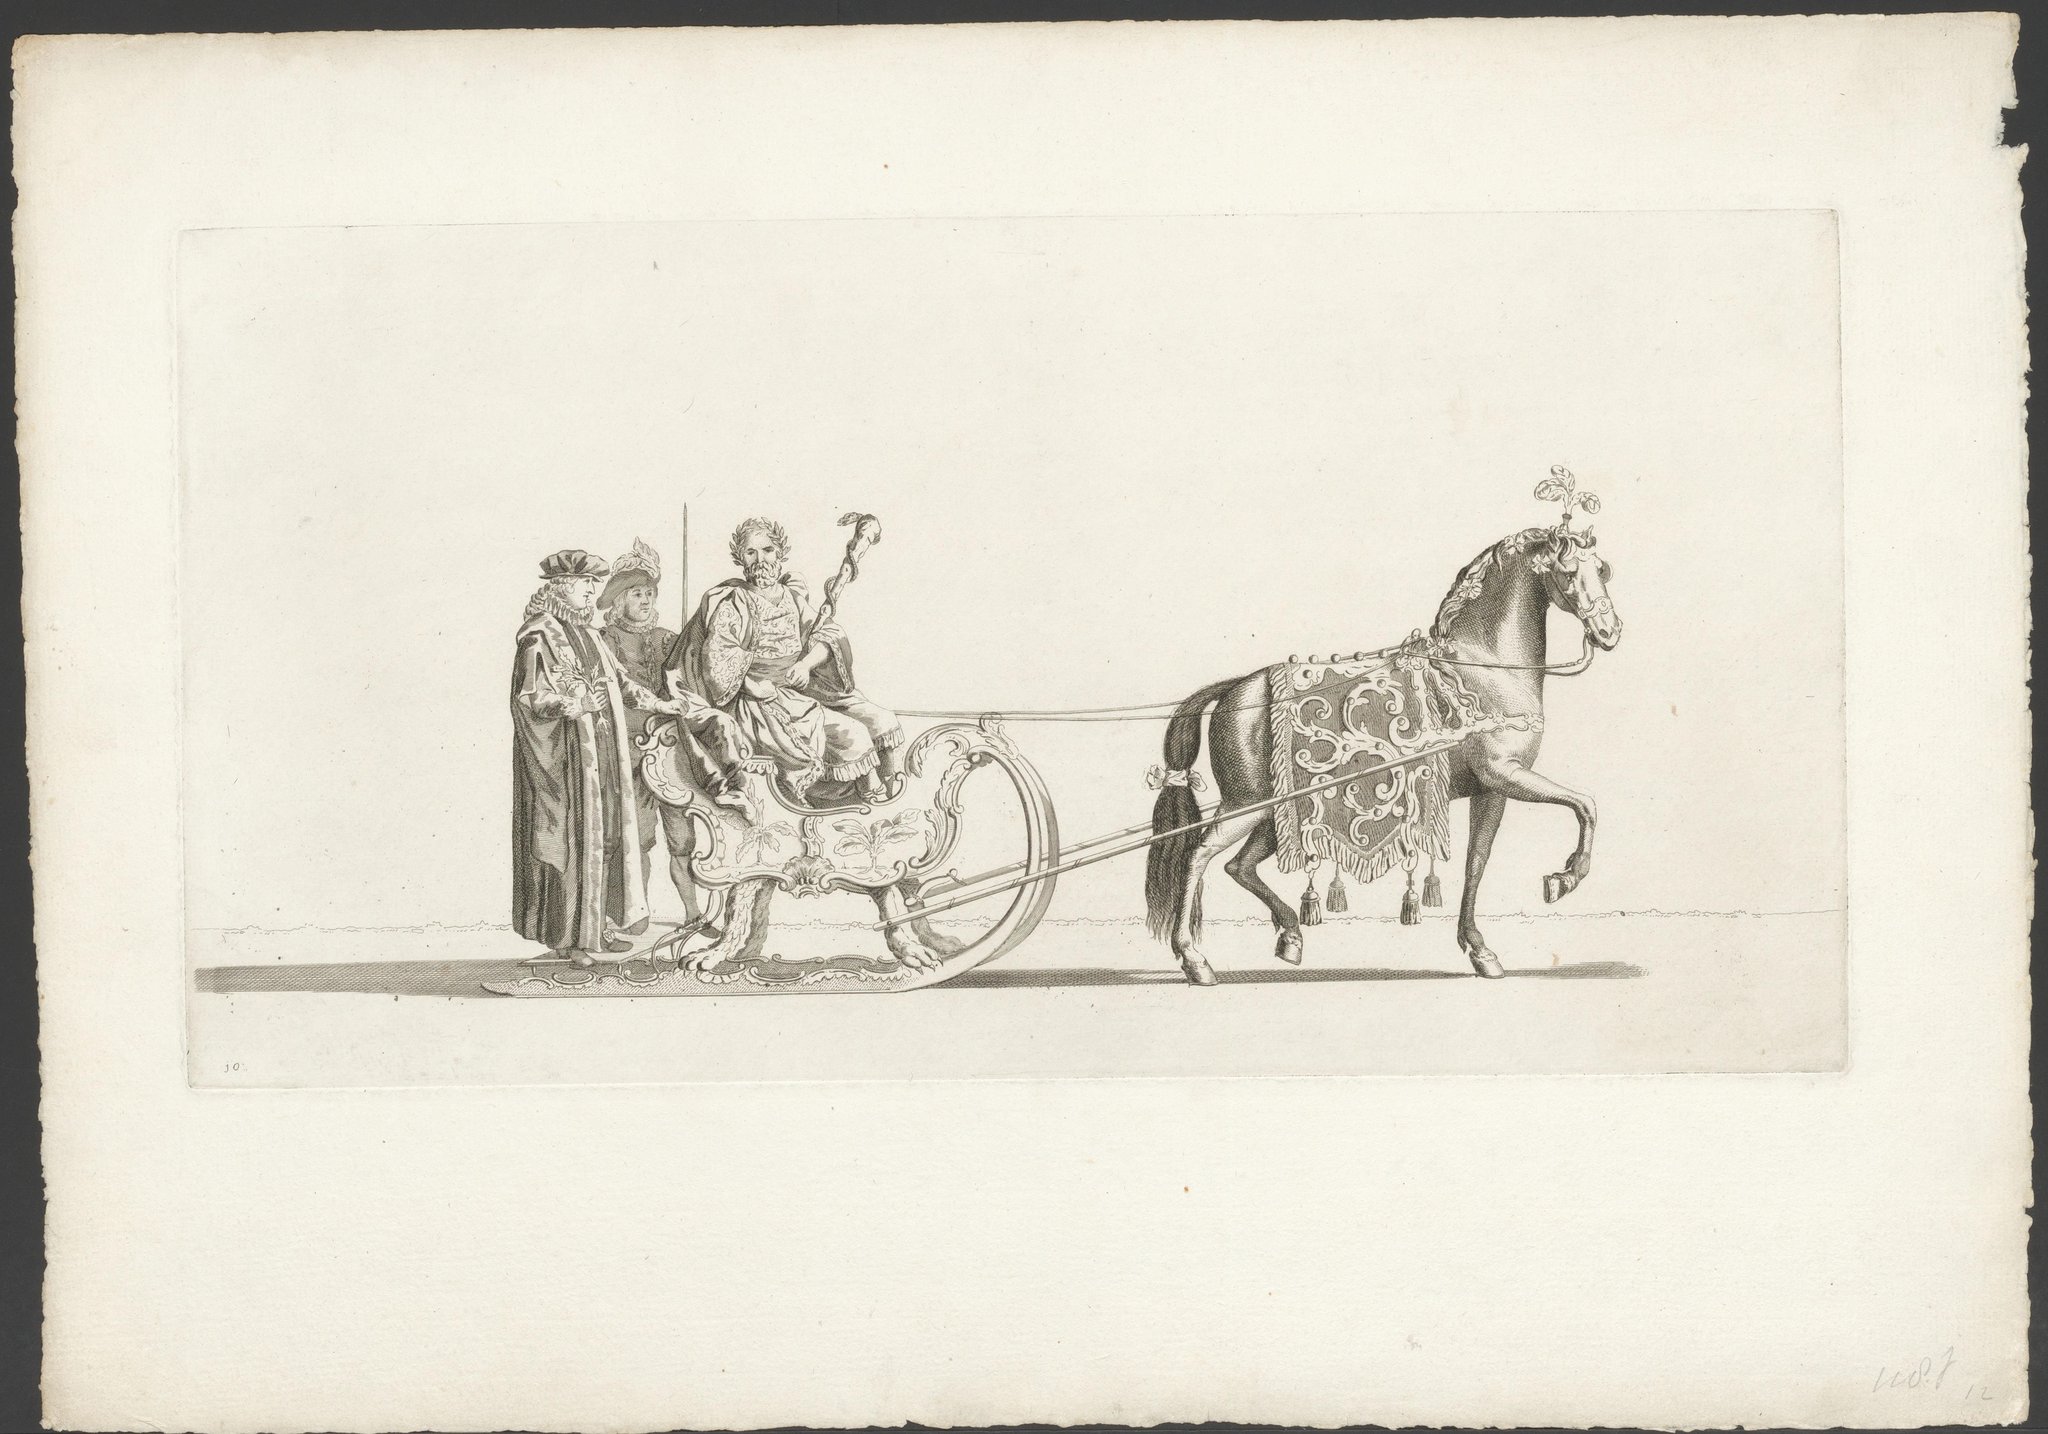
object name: print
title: Tiende slede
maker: nicolaas van der worm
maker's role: draughtsman, print maker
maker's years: 1757-1828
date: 1776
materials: paper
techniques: engraving, etching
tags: sledge, sleigh (winter sports), commemoration of the founding of a university, leiden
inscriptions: signature: ‘Dant: Hendr: Righout’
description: De tiende slede in de optocht. Een slede met Asclepius (Aesculapius), getrokken door een paard. Onderdeel van een reeks van twaalf platen van de sledevaart op 24 januari 1776 georganiseerd door het Leidse genootschap Veniam Pro Laude bij gelegenheid van het Tweede Eeuwfeest van het Leids Ontzet (3 oktober 1574) en de oprichting van de Universiteit van Leiden (8 februari 1575). Linksonder genummerd: 10. Onderwerpsrubrieken binnen de Atlas Zeden en Gewoonten: Onderwijs en Wetenschappen, Studentenleven.